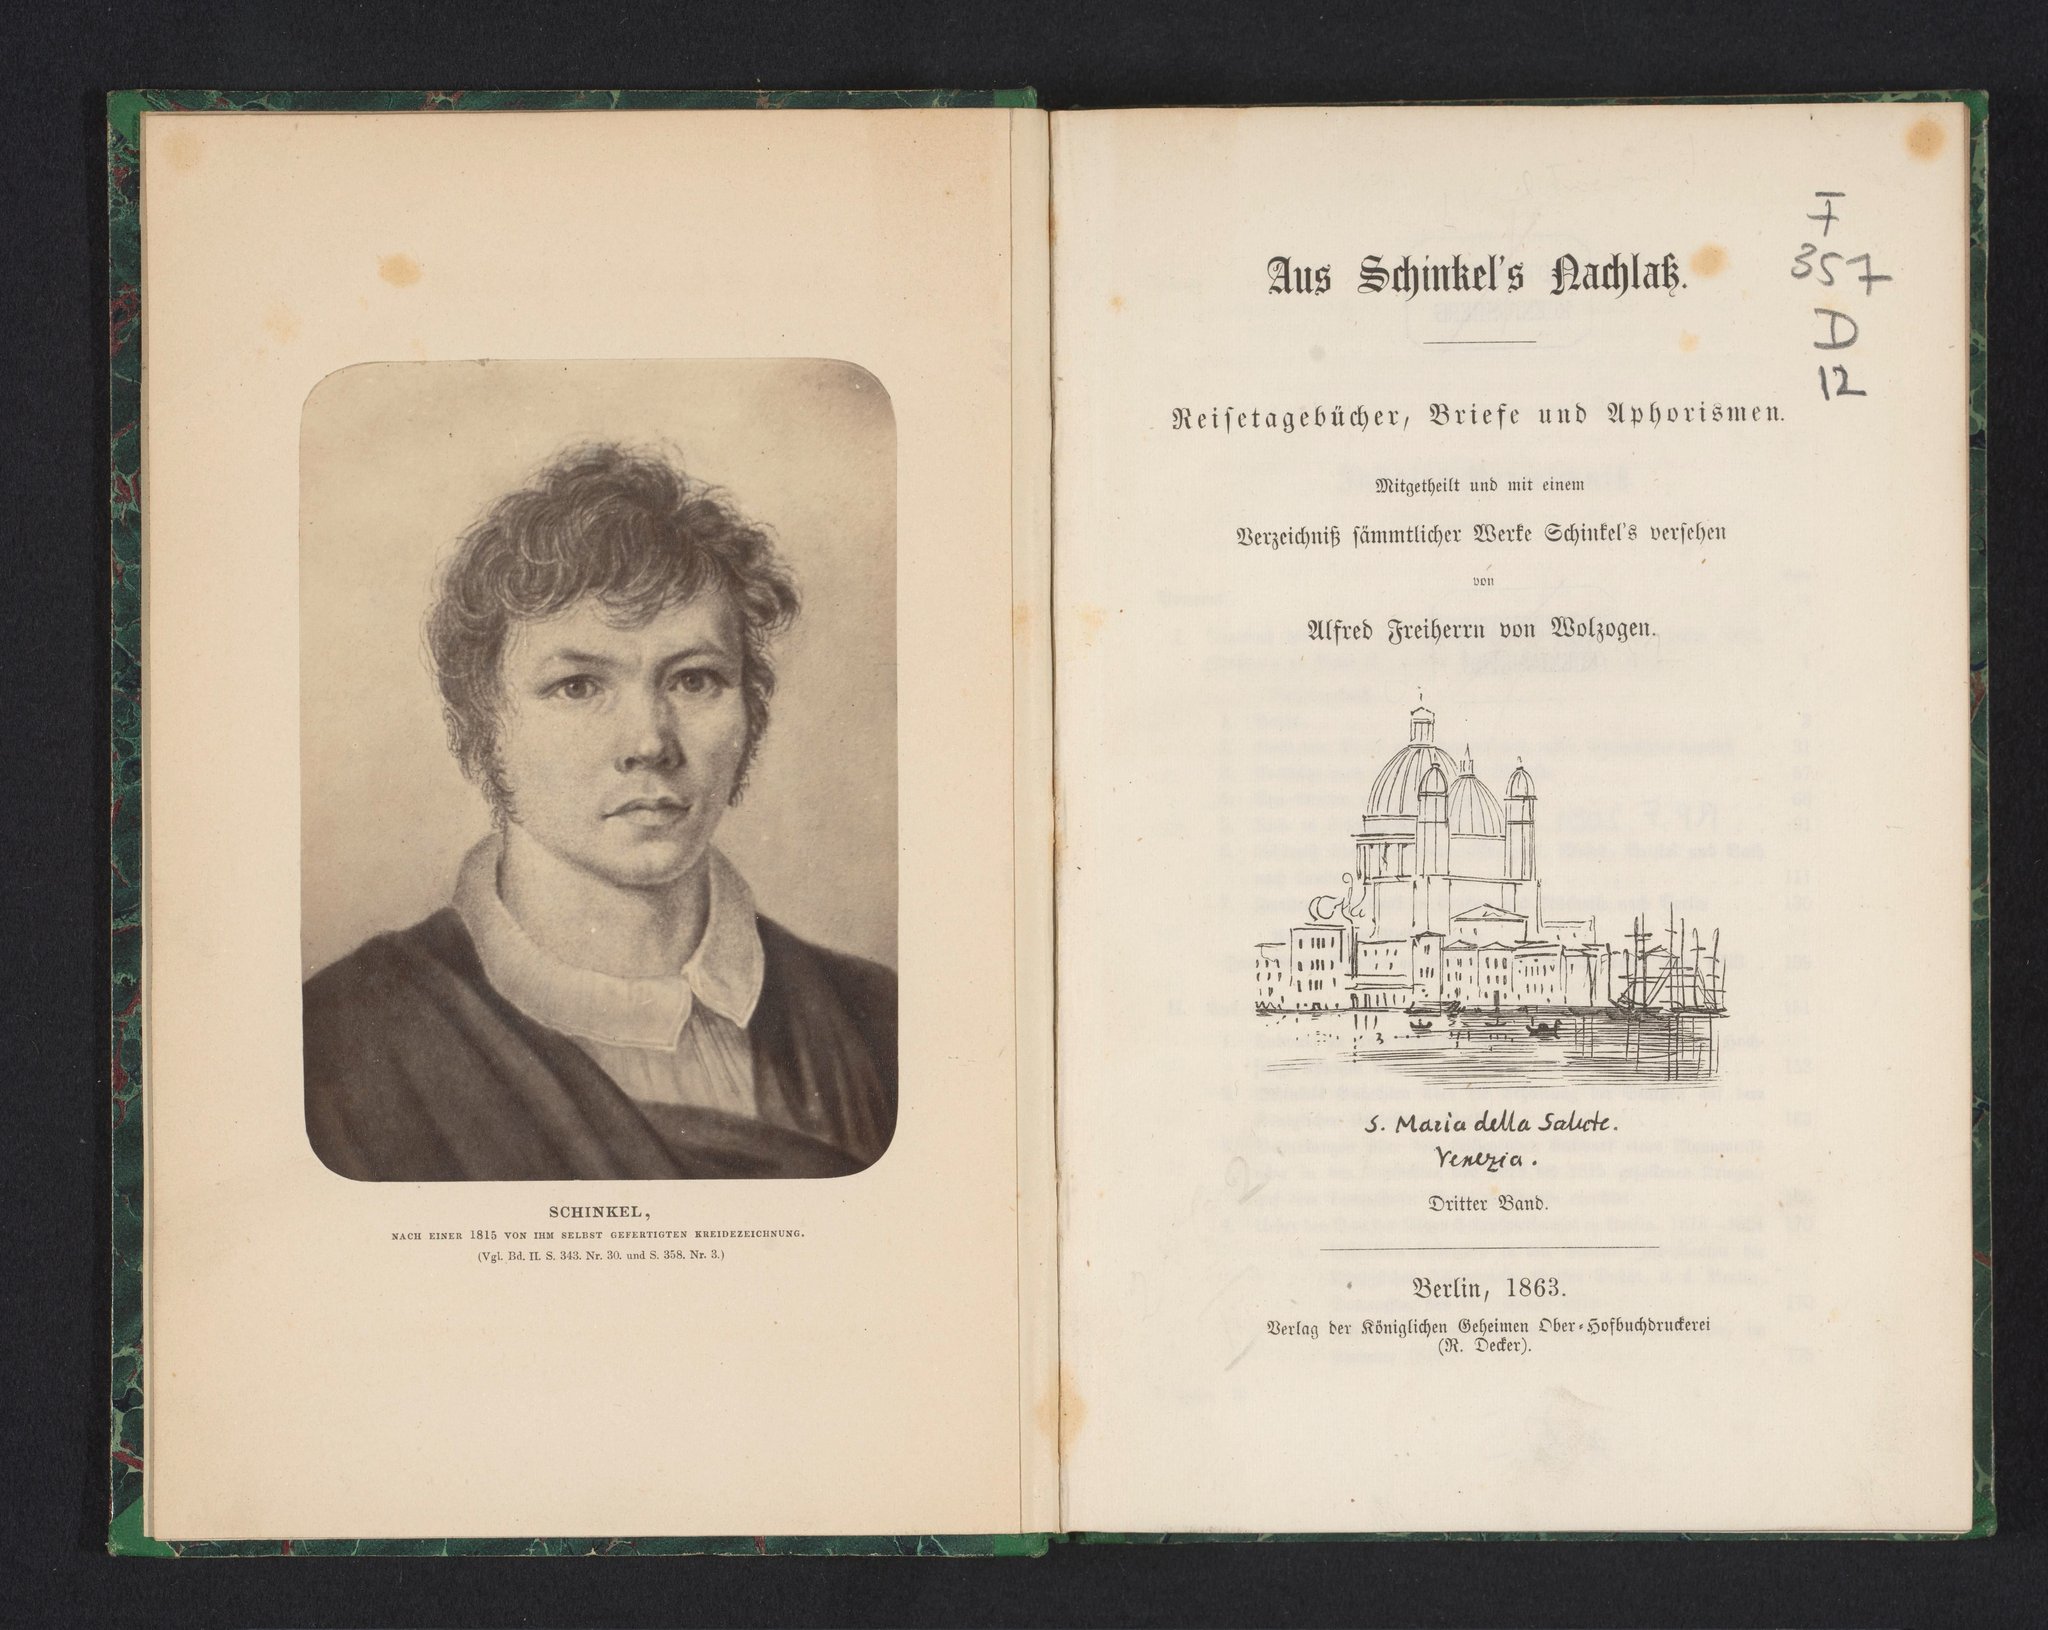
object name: book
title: Aus Schinkel's Nachlass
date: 1862-1863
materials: cardboard, linen, paper, photographic support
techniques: albumen print, printing, marbled paper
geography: berlin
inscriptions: inscription: ‘Stadtbibliothek Koenigsberg’